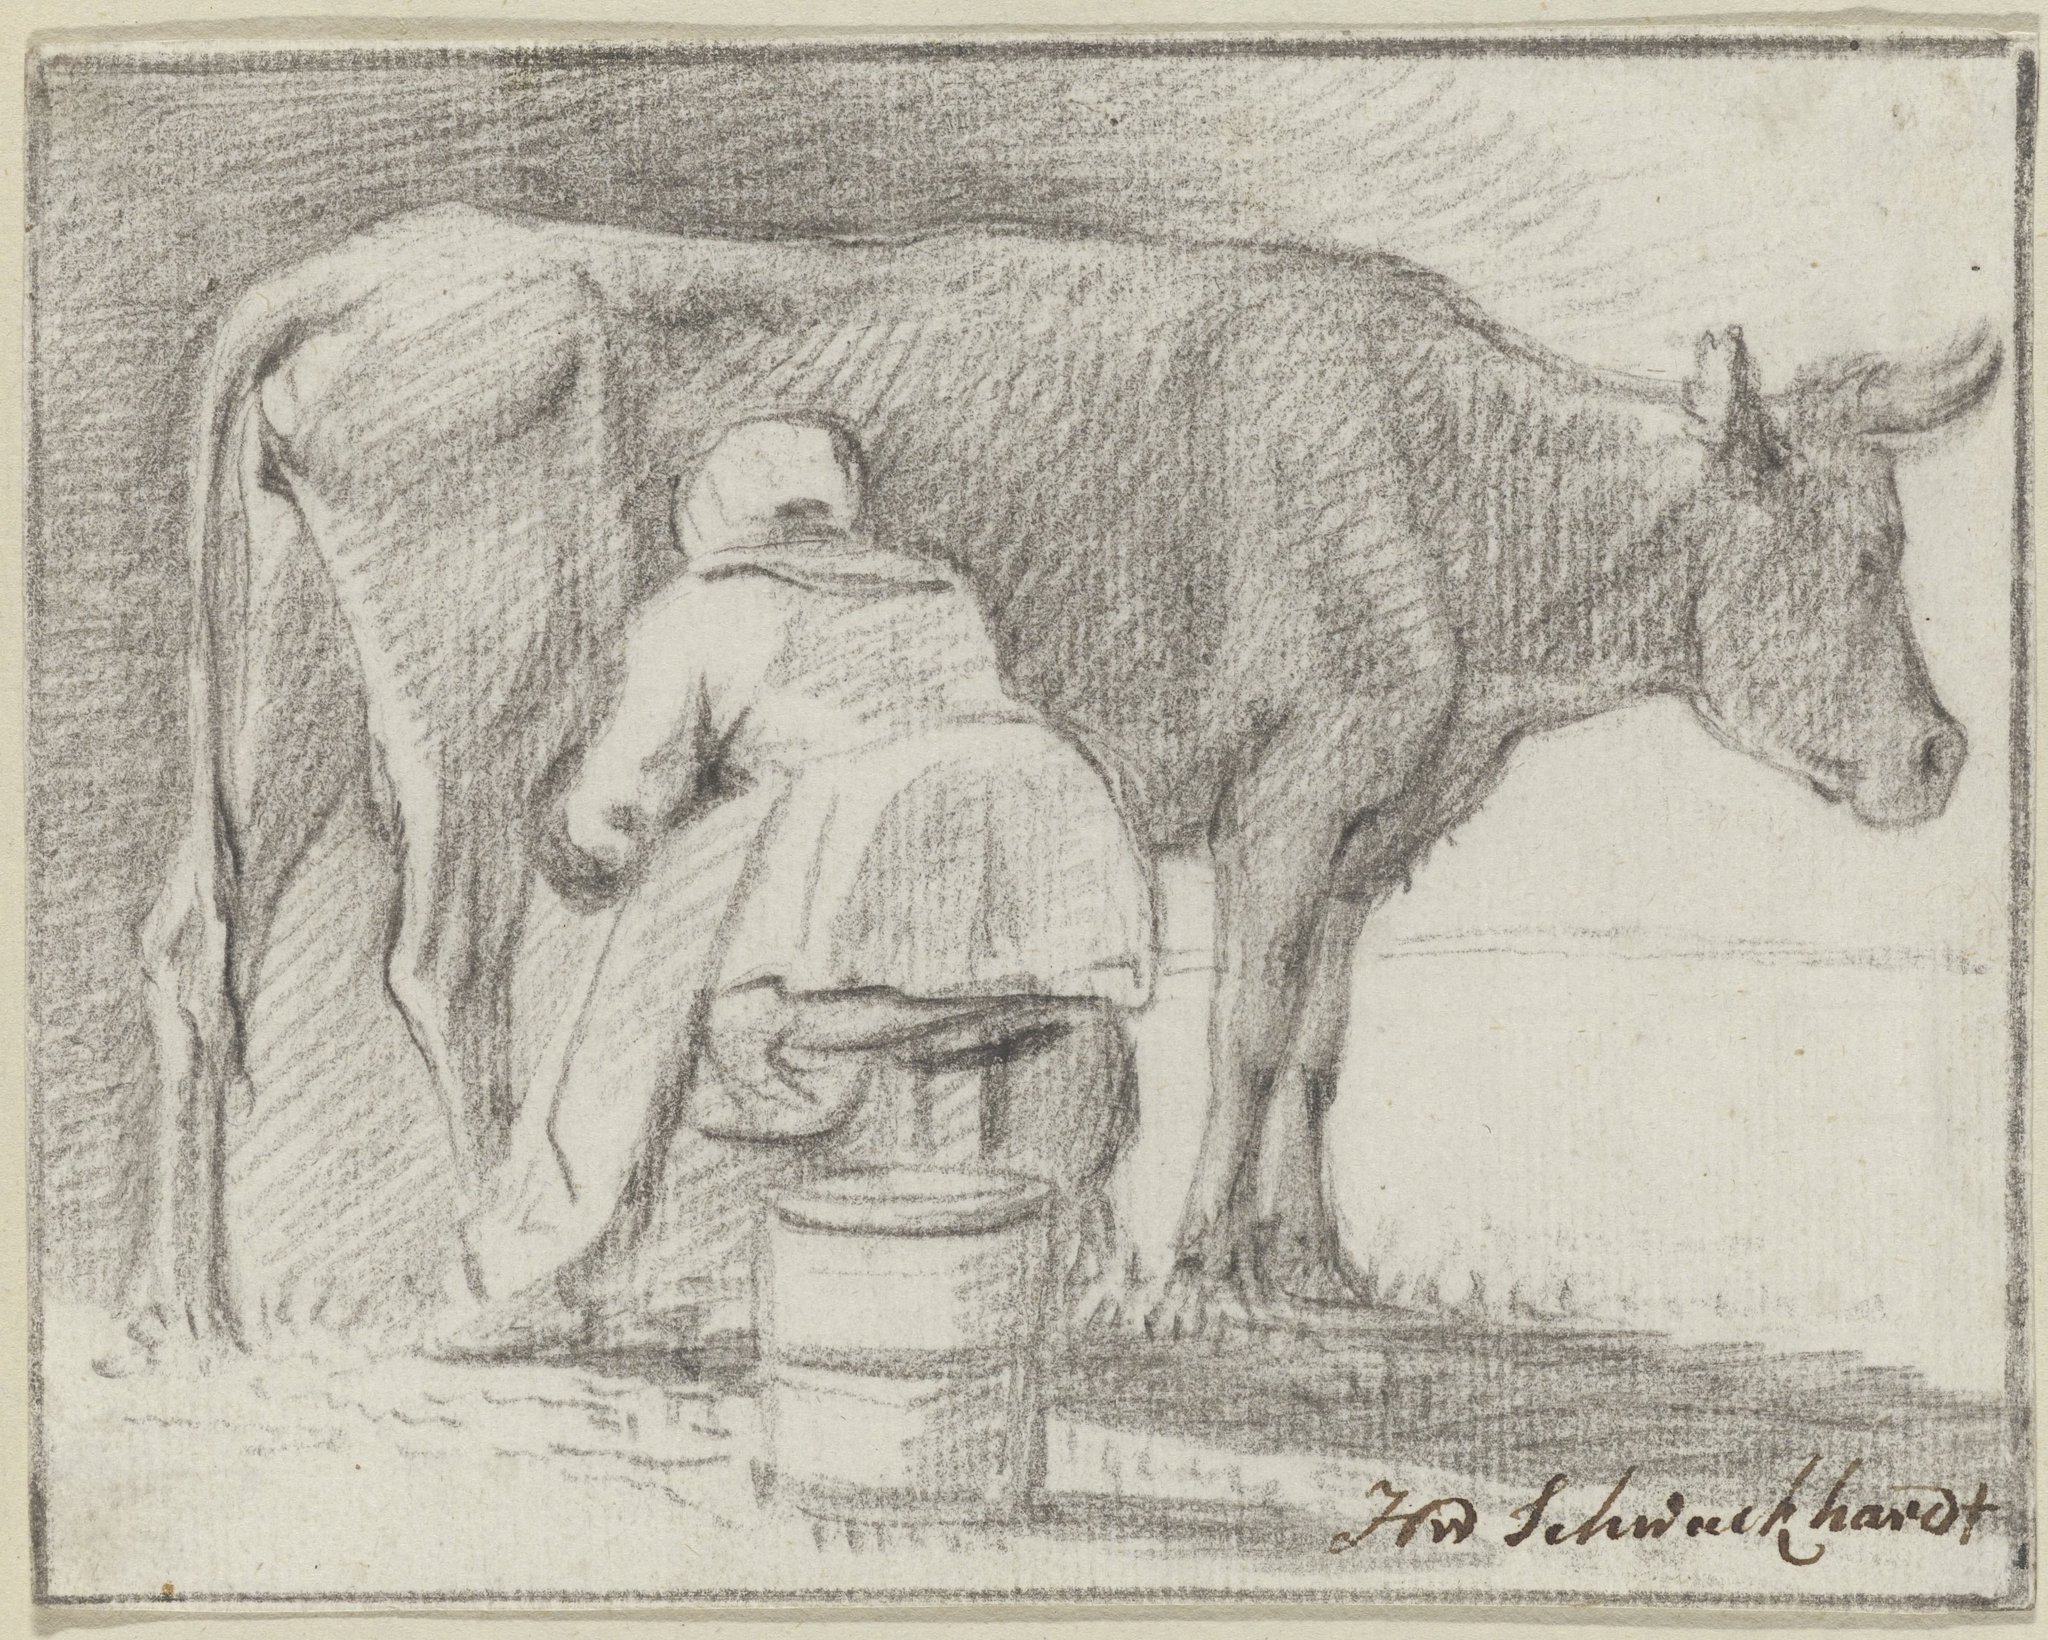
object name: drawing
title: Koemelkende vrouw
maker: hendrik willem schweickhardt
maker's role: draughtsman, painter, print maker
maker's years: 1746-1797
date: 1756-1797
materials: chalk, paper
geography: netherlands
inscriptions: signature: ‘HW Schweickhardt’